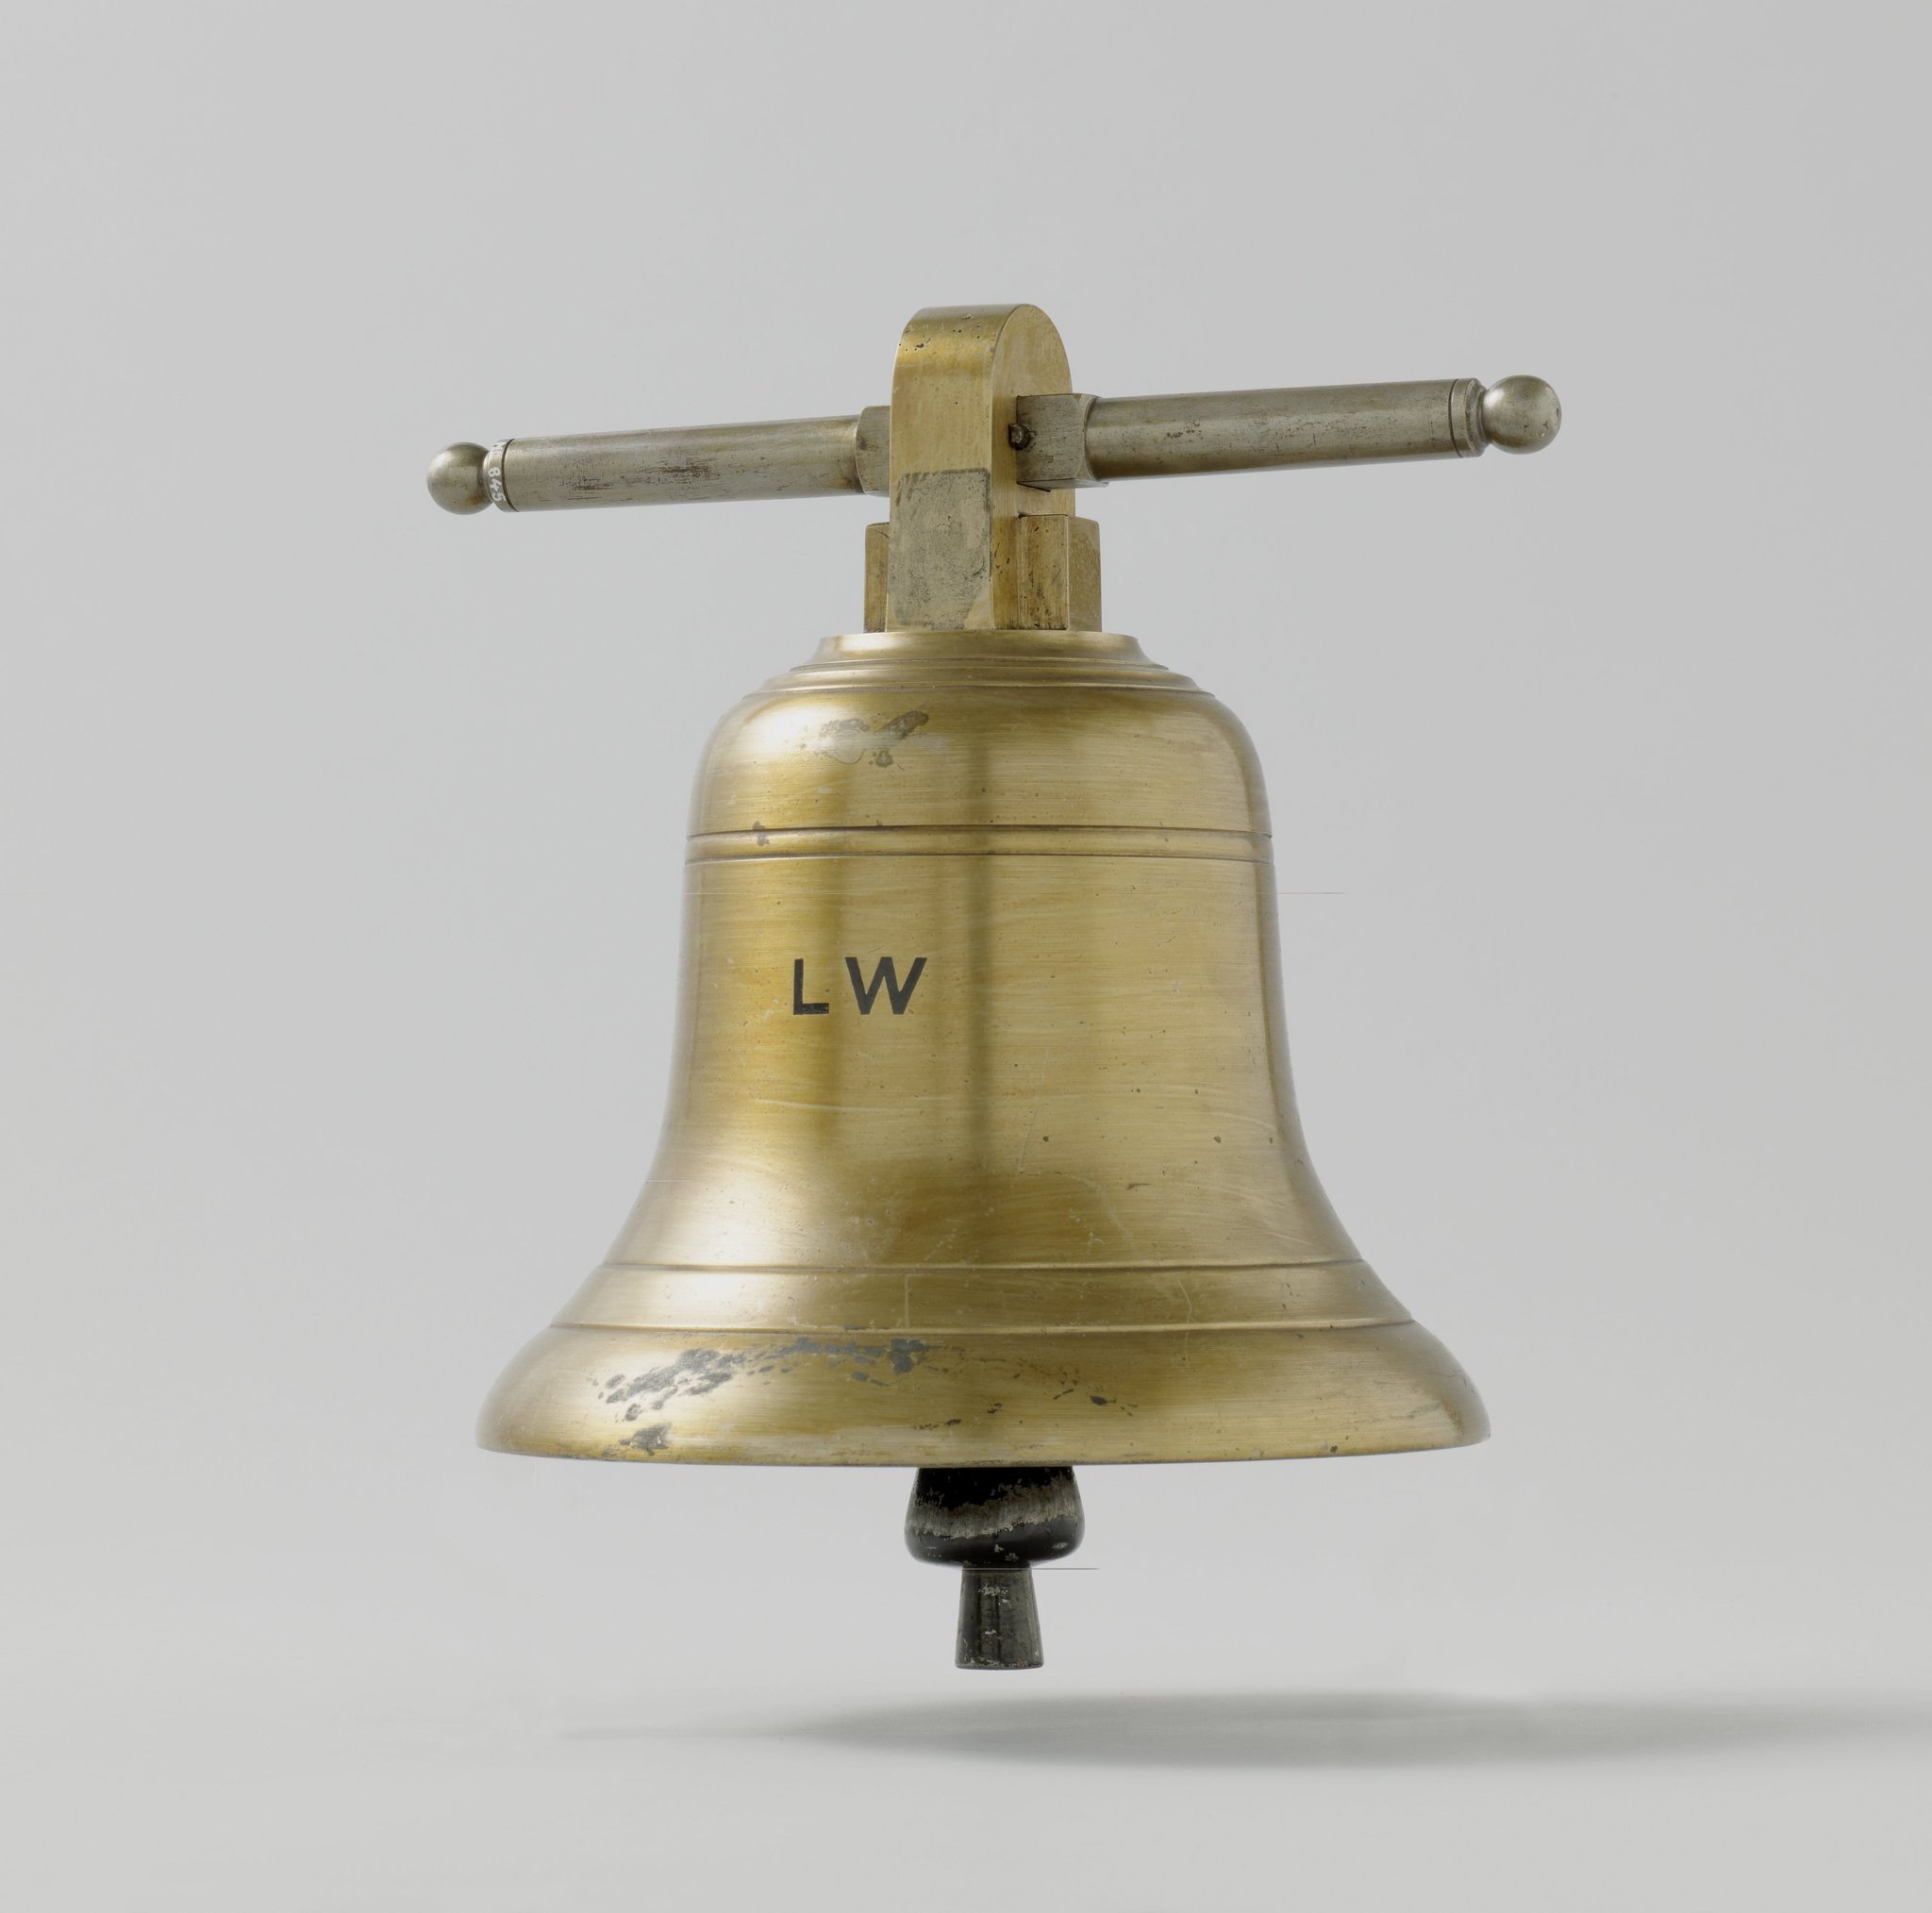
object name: musical instrument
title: Ship bell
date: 1854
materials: bronze, iron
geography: rotterdam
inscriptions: inscription, on the bell: ‘LW’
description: Bij Koninklijk Besluit nr. 54 van 12 juni 1858 werden alle zeezeilschepen verplicht een dergelijke scheepsbel aan boord te hebben en te luiden als zij bij mist over stuurboord zeilden.